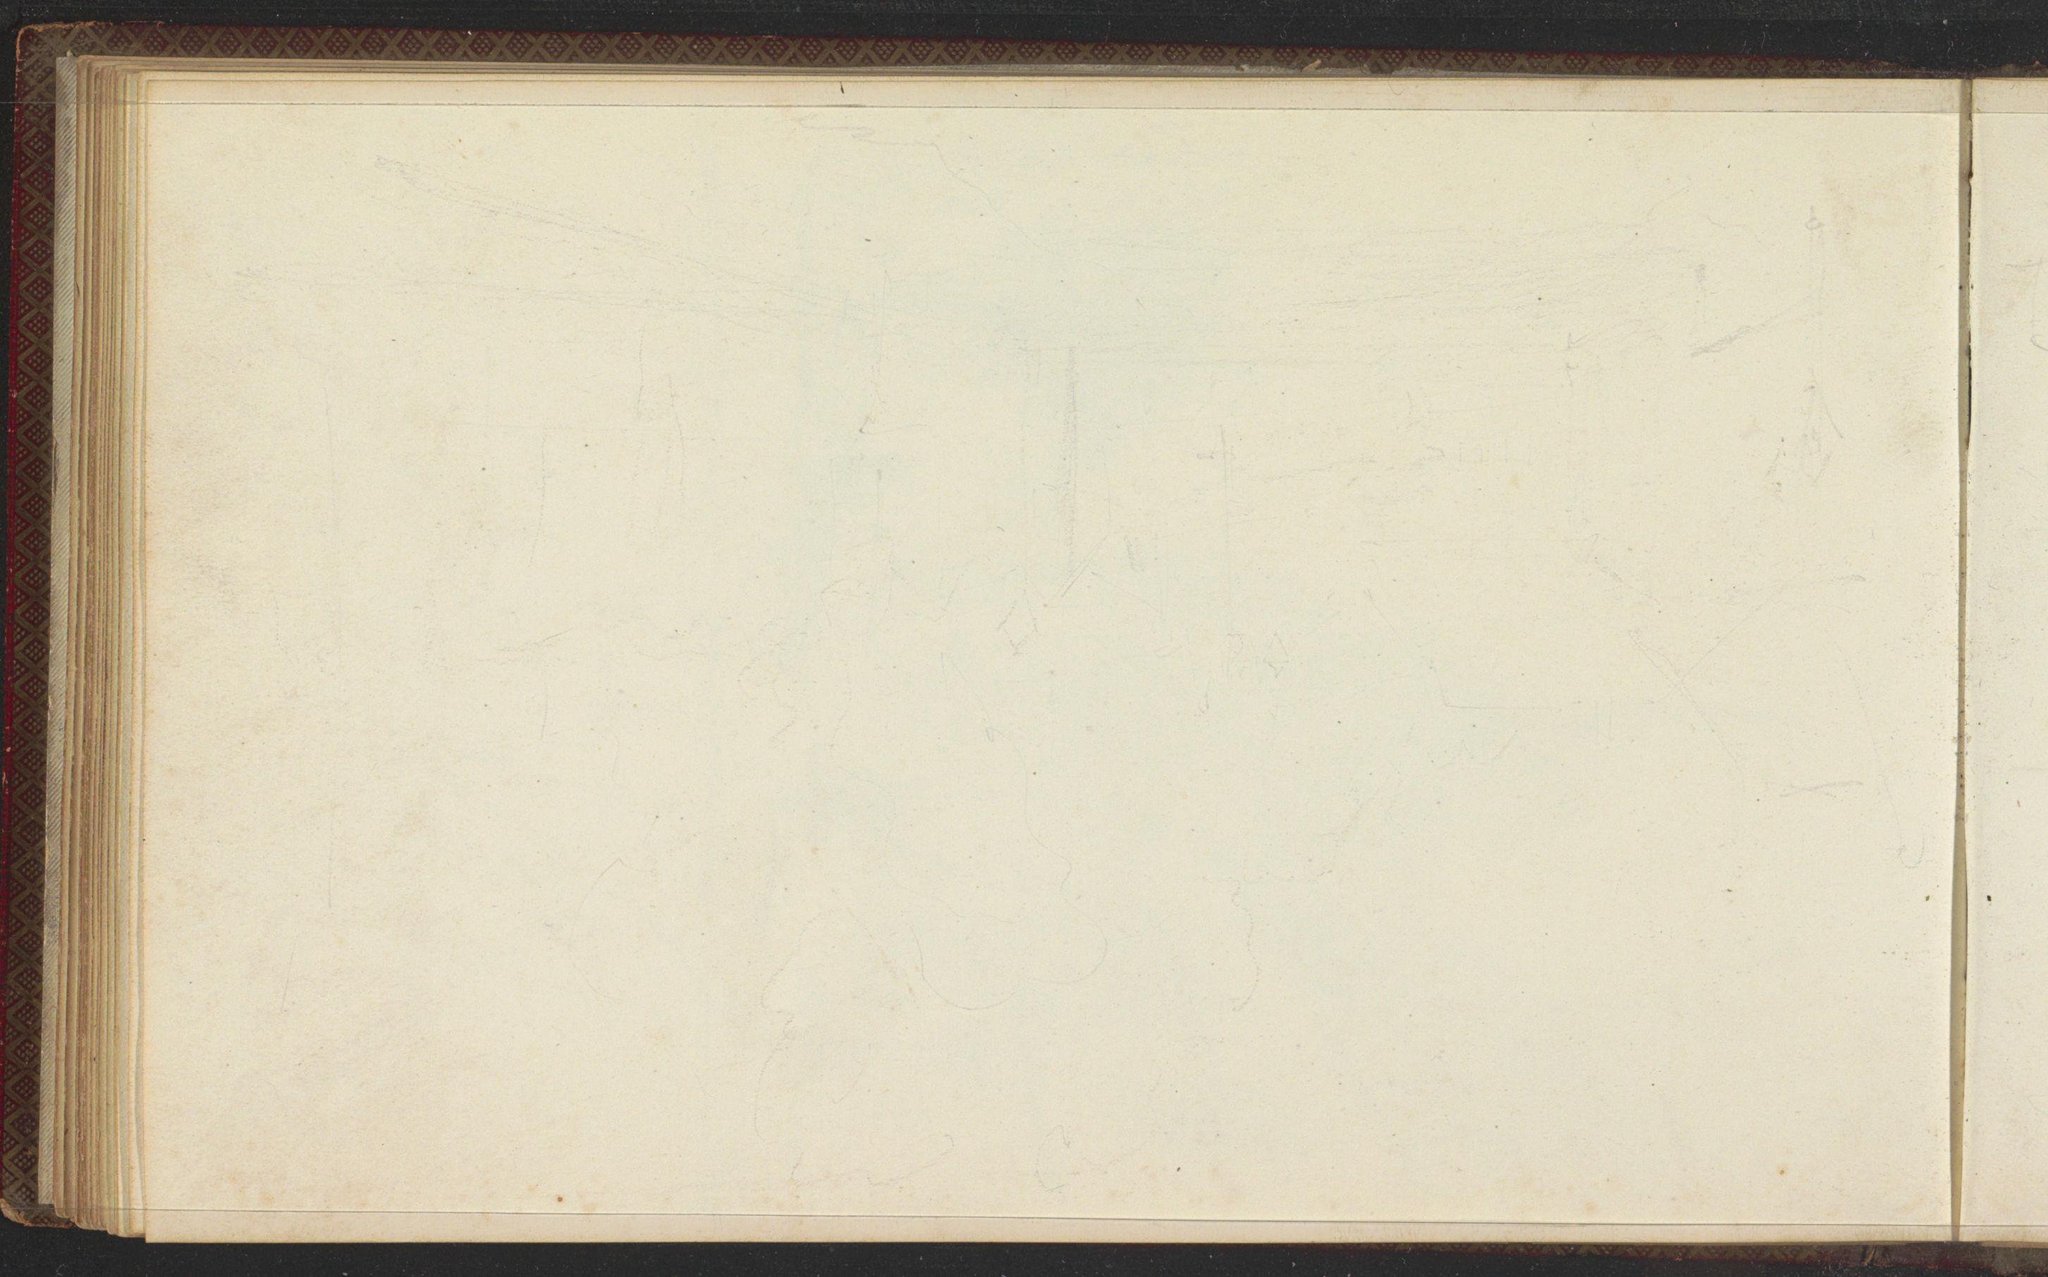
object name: sketchbook leaf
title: Gezicht op gebouwen en bomen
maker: adrianus eversen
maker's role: draughtsman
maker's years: 1818-1897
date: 1828-1897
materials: paper, pencil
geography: netherlands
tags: city-view, and landscape with man-made constructions, trees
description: Gezicht op gebouwen en bomen. Blad 38 verso uit een schetsboek met 52 bladen vervaardigd in de omgeving van Kampen, Hattem, Hoorn en Zwolle.